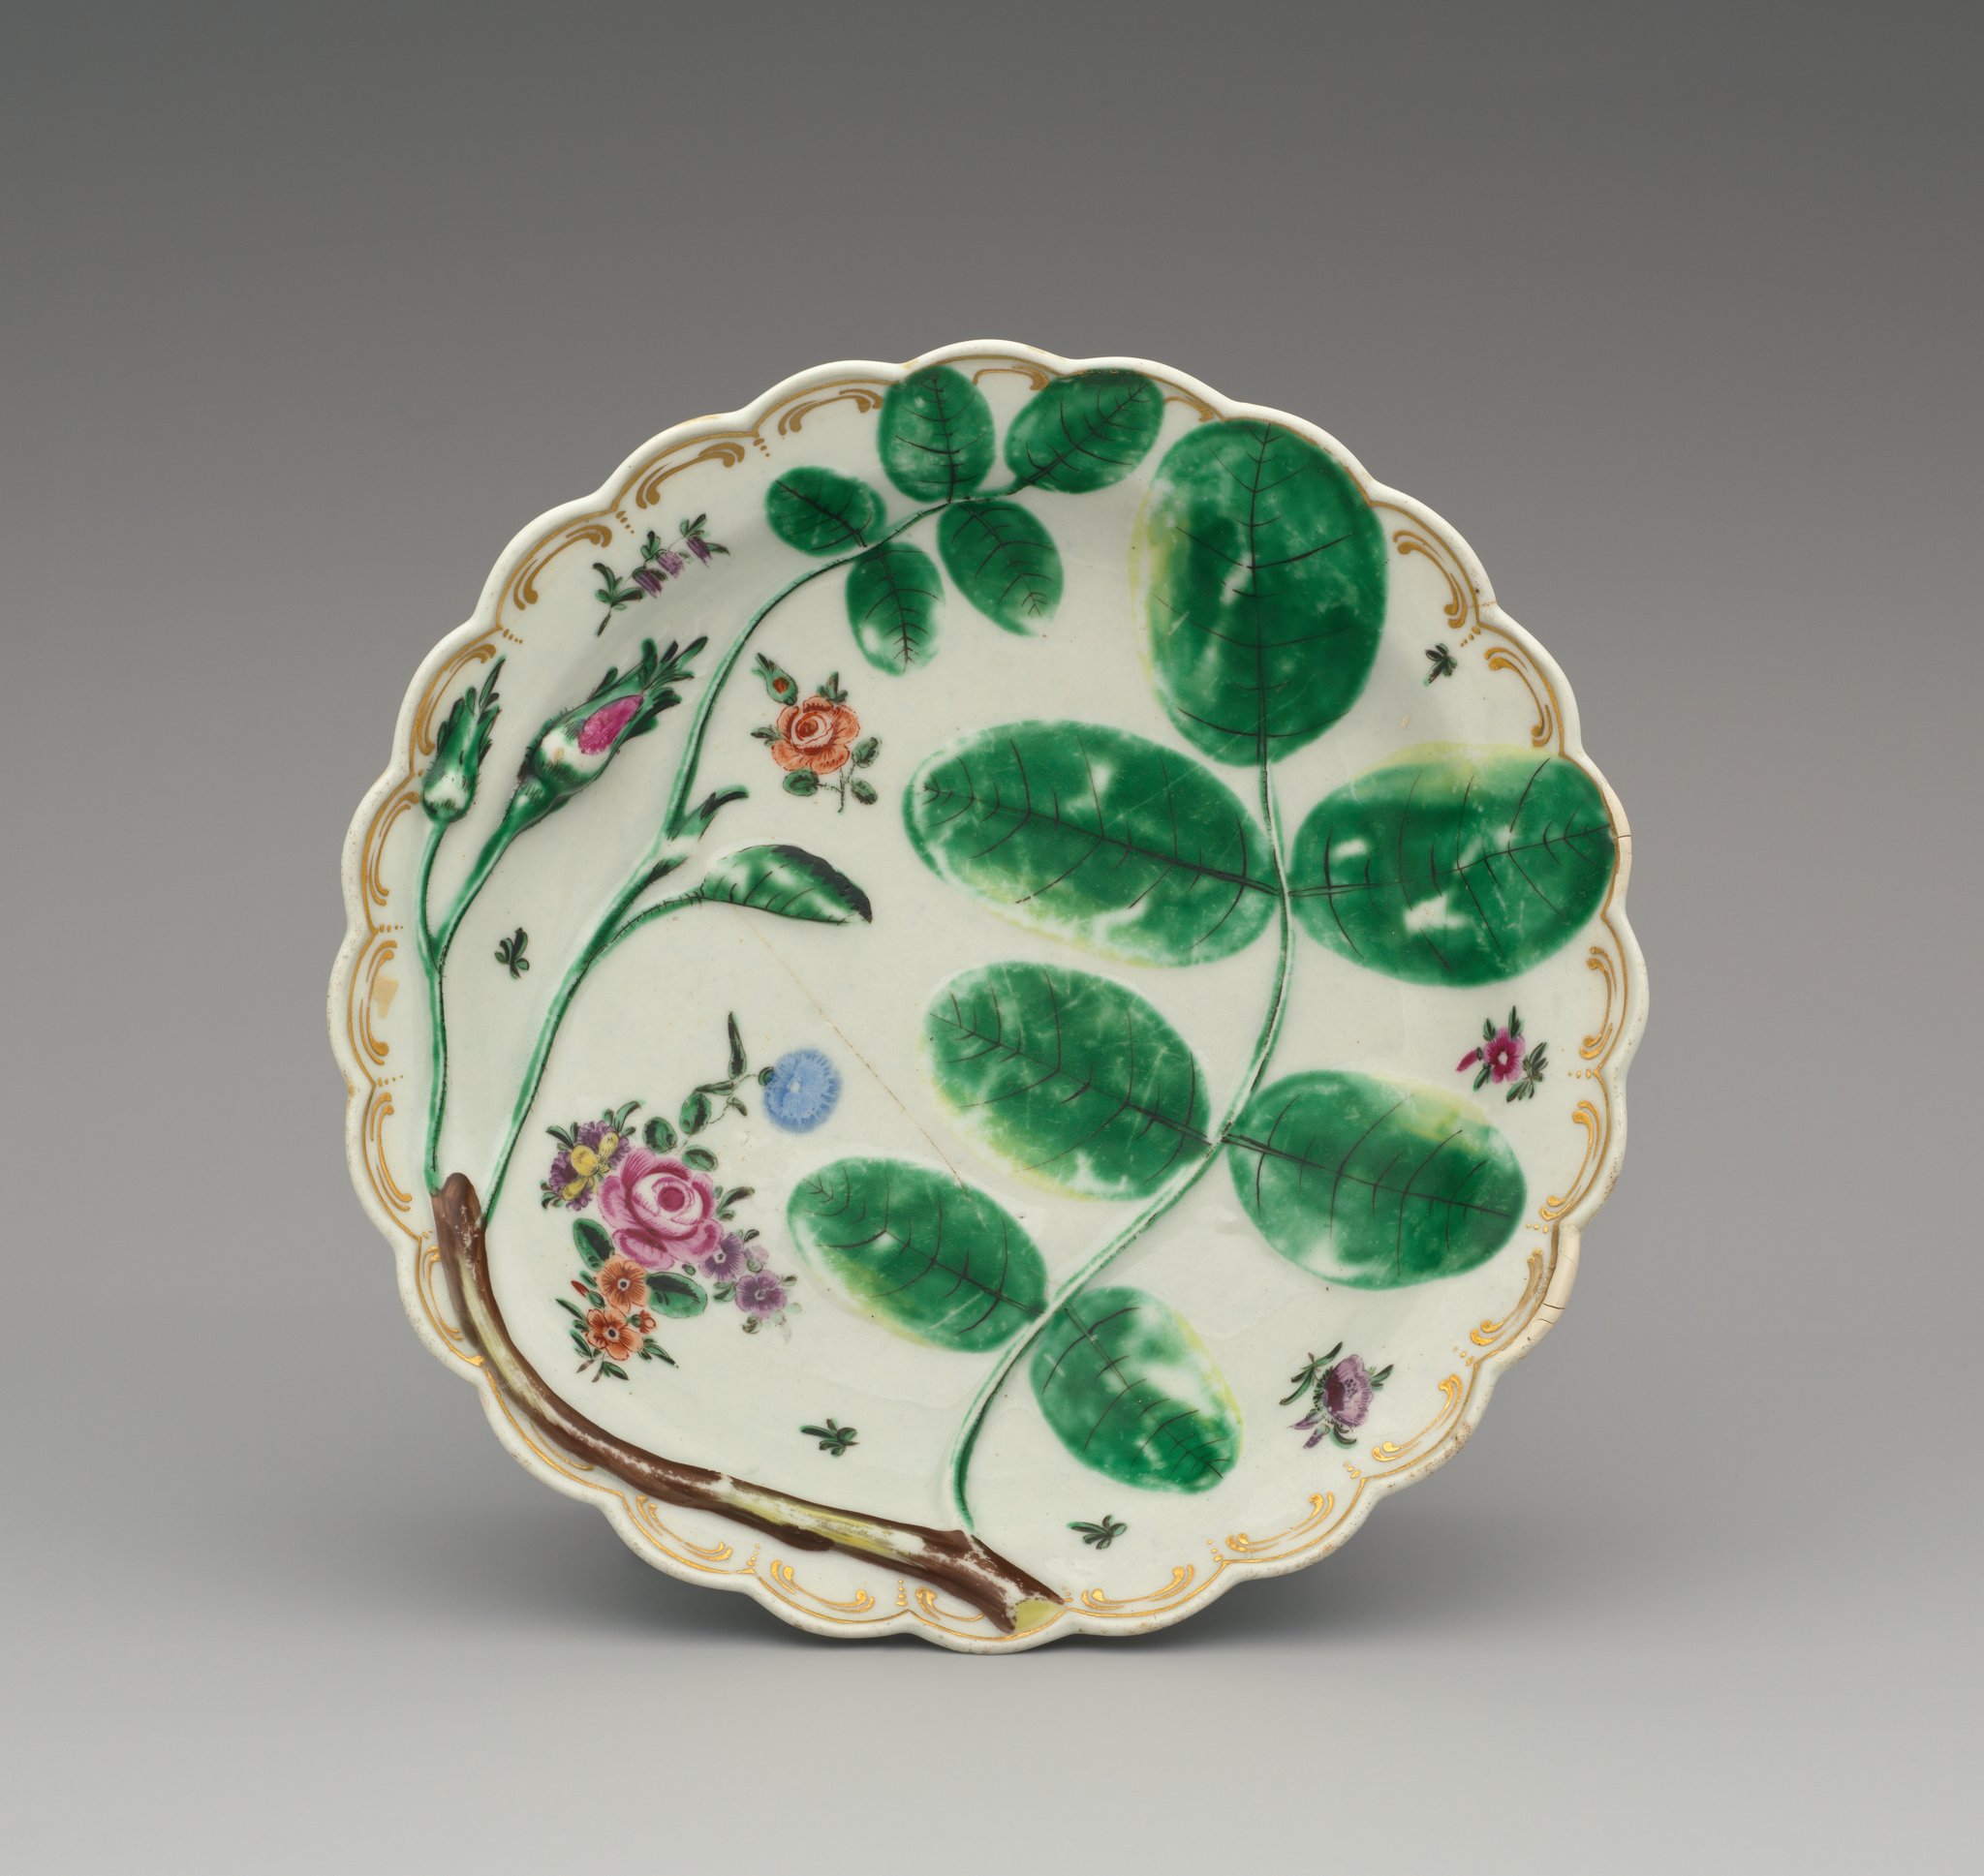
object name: plate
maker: worcester factory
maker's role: factory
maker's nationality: british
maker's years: 1751-2008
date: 1770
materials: soft paste porcelain